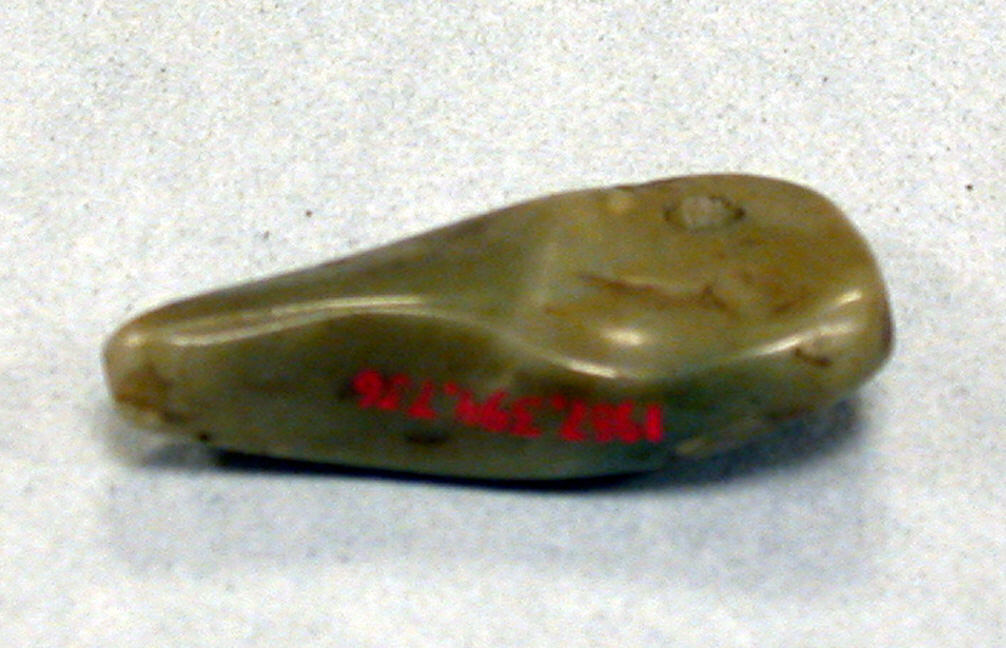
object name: pendant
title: Stone Tooth Pendant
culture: costa rican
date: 801-1500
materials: stone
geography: costa rica